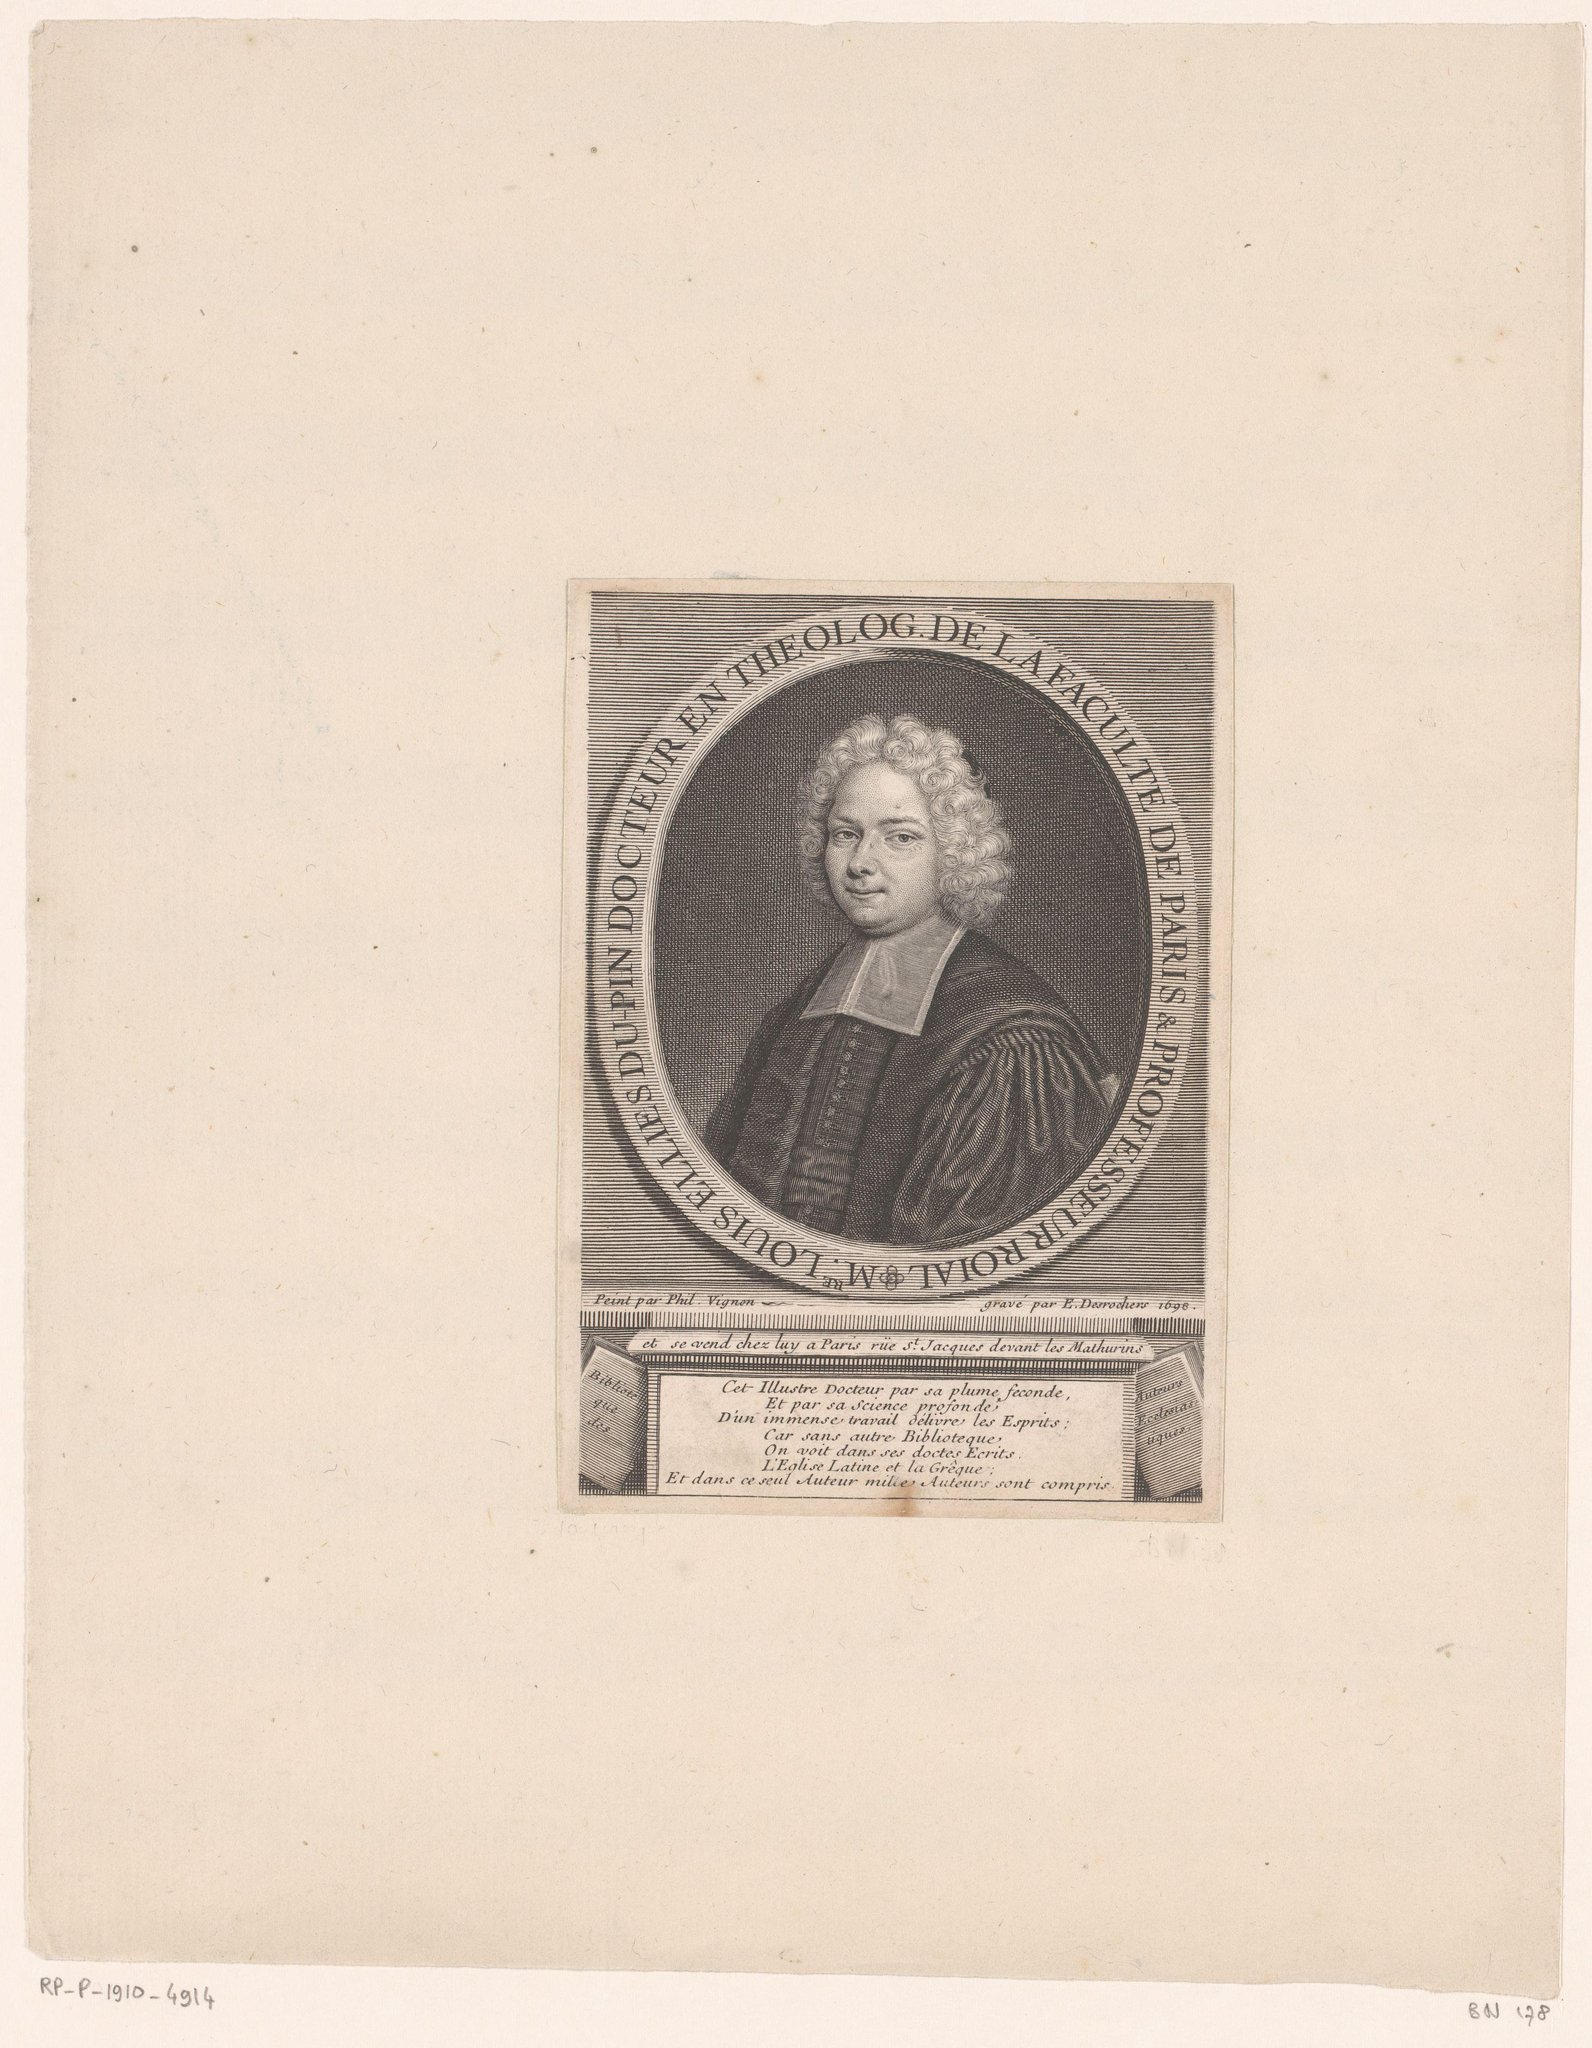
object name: print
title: Recueil de portraits (...)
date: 1698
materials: paper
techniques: engraving, etching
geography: paris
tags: theologian, historical persons, professor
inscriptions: collector's mark: Lugt 2228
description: Behoort waarschijnlijk tot een serie portretten, grotendeels door Etienne Desrochers, getiteld: 'Recueil de portraits de personnes qui se sont distinguées tant dans les Armes que dans Belles-Lettres et les Arts, comme aussi la famille royale de France et autres cours étrangères'. De serie werd initieel uitgegeven door Desrochers en aangekondigd in 'Mercure' in mei 1726, p. 985. Echter was Desrochers reeds enkele jaren eerder begonnen met het uitgeven van de serie. Na de dood van Desrochers werd de serie voortgezet door Gilles Edme Petit. Een latere staat werd uitgegeven door Jean François Daumont in Parijs.